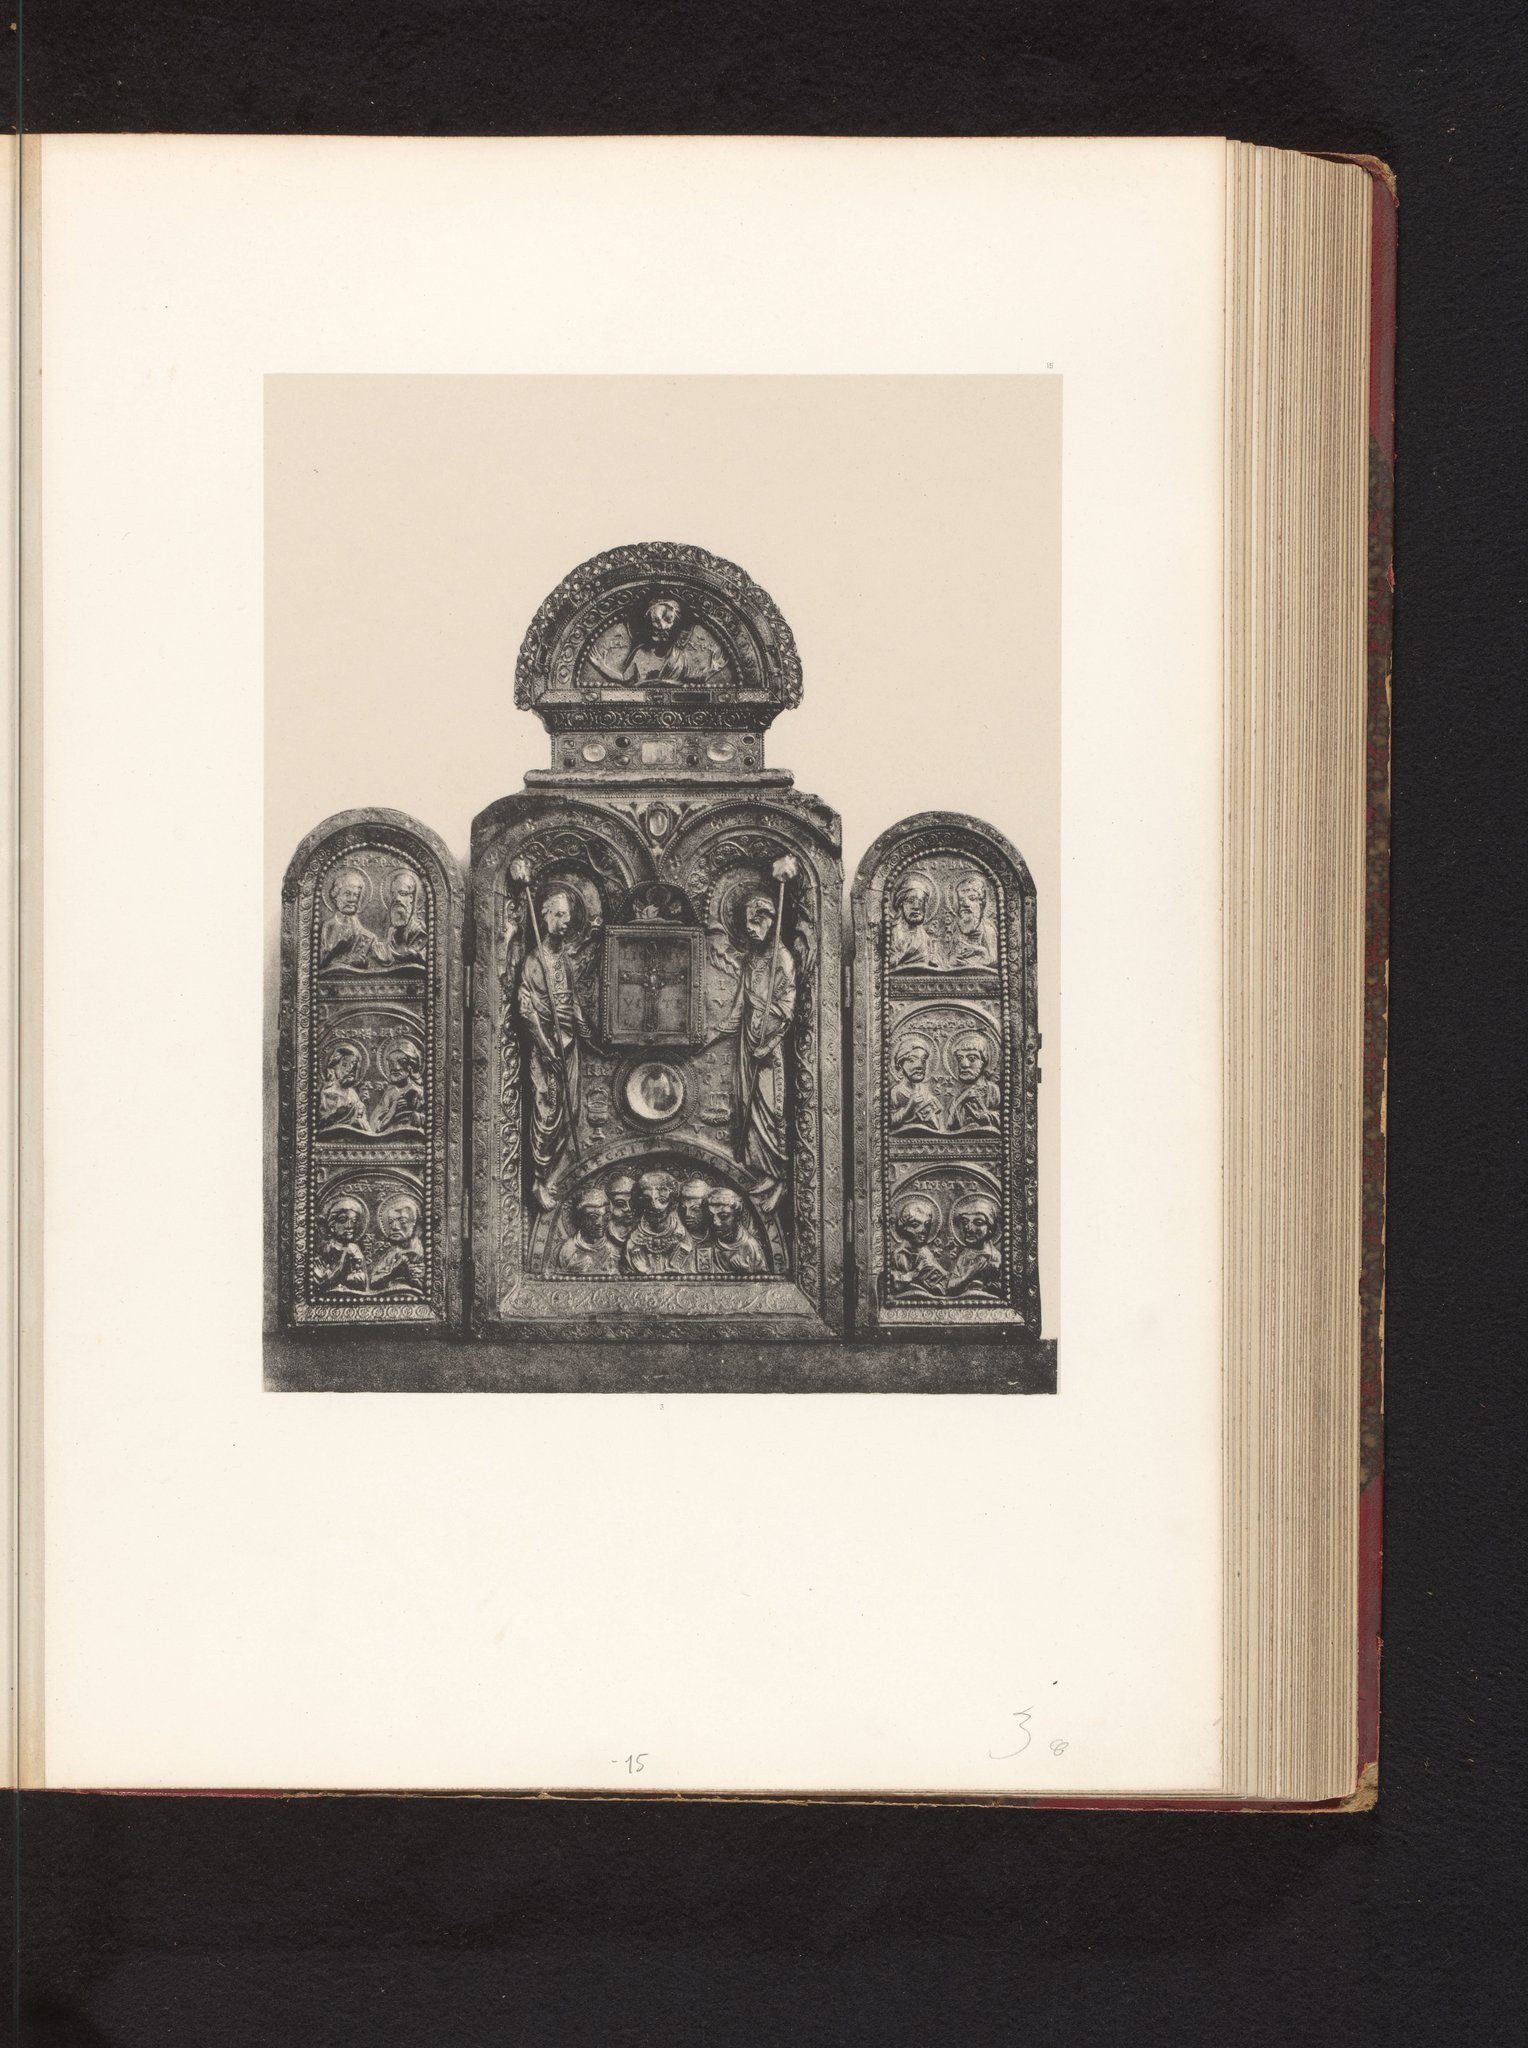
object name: page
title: Drieluik van hout, koper en email met relikwie, uit de Heilige Kruiskerk in Luik, opgesteld op een tentoonstelling over religieuze objecten uit de middeleeuwen en renaissance in 1864 in Mechelen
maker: joseph maes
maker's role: fotograaf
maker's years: 1838-1908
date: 1864-1866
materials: paper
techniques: photolithography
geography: antwerp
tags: piece of sculpture, reproduction of a piece of sculpture (+ wood, e.g.: panel ~ arts), relics (and reliquaries), mechelen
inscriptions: number: ‘3’, number: ‘-15’, number: ‘3’